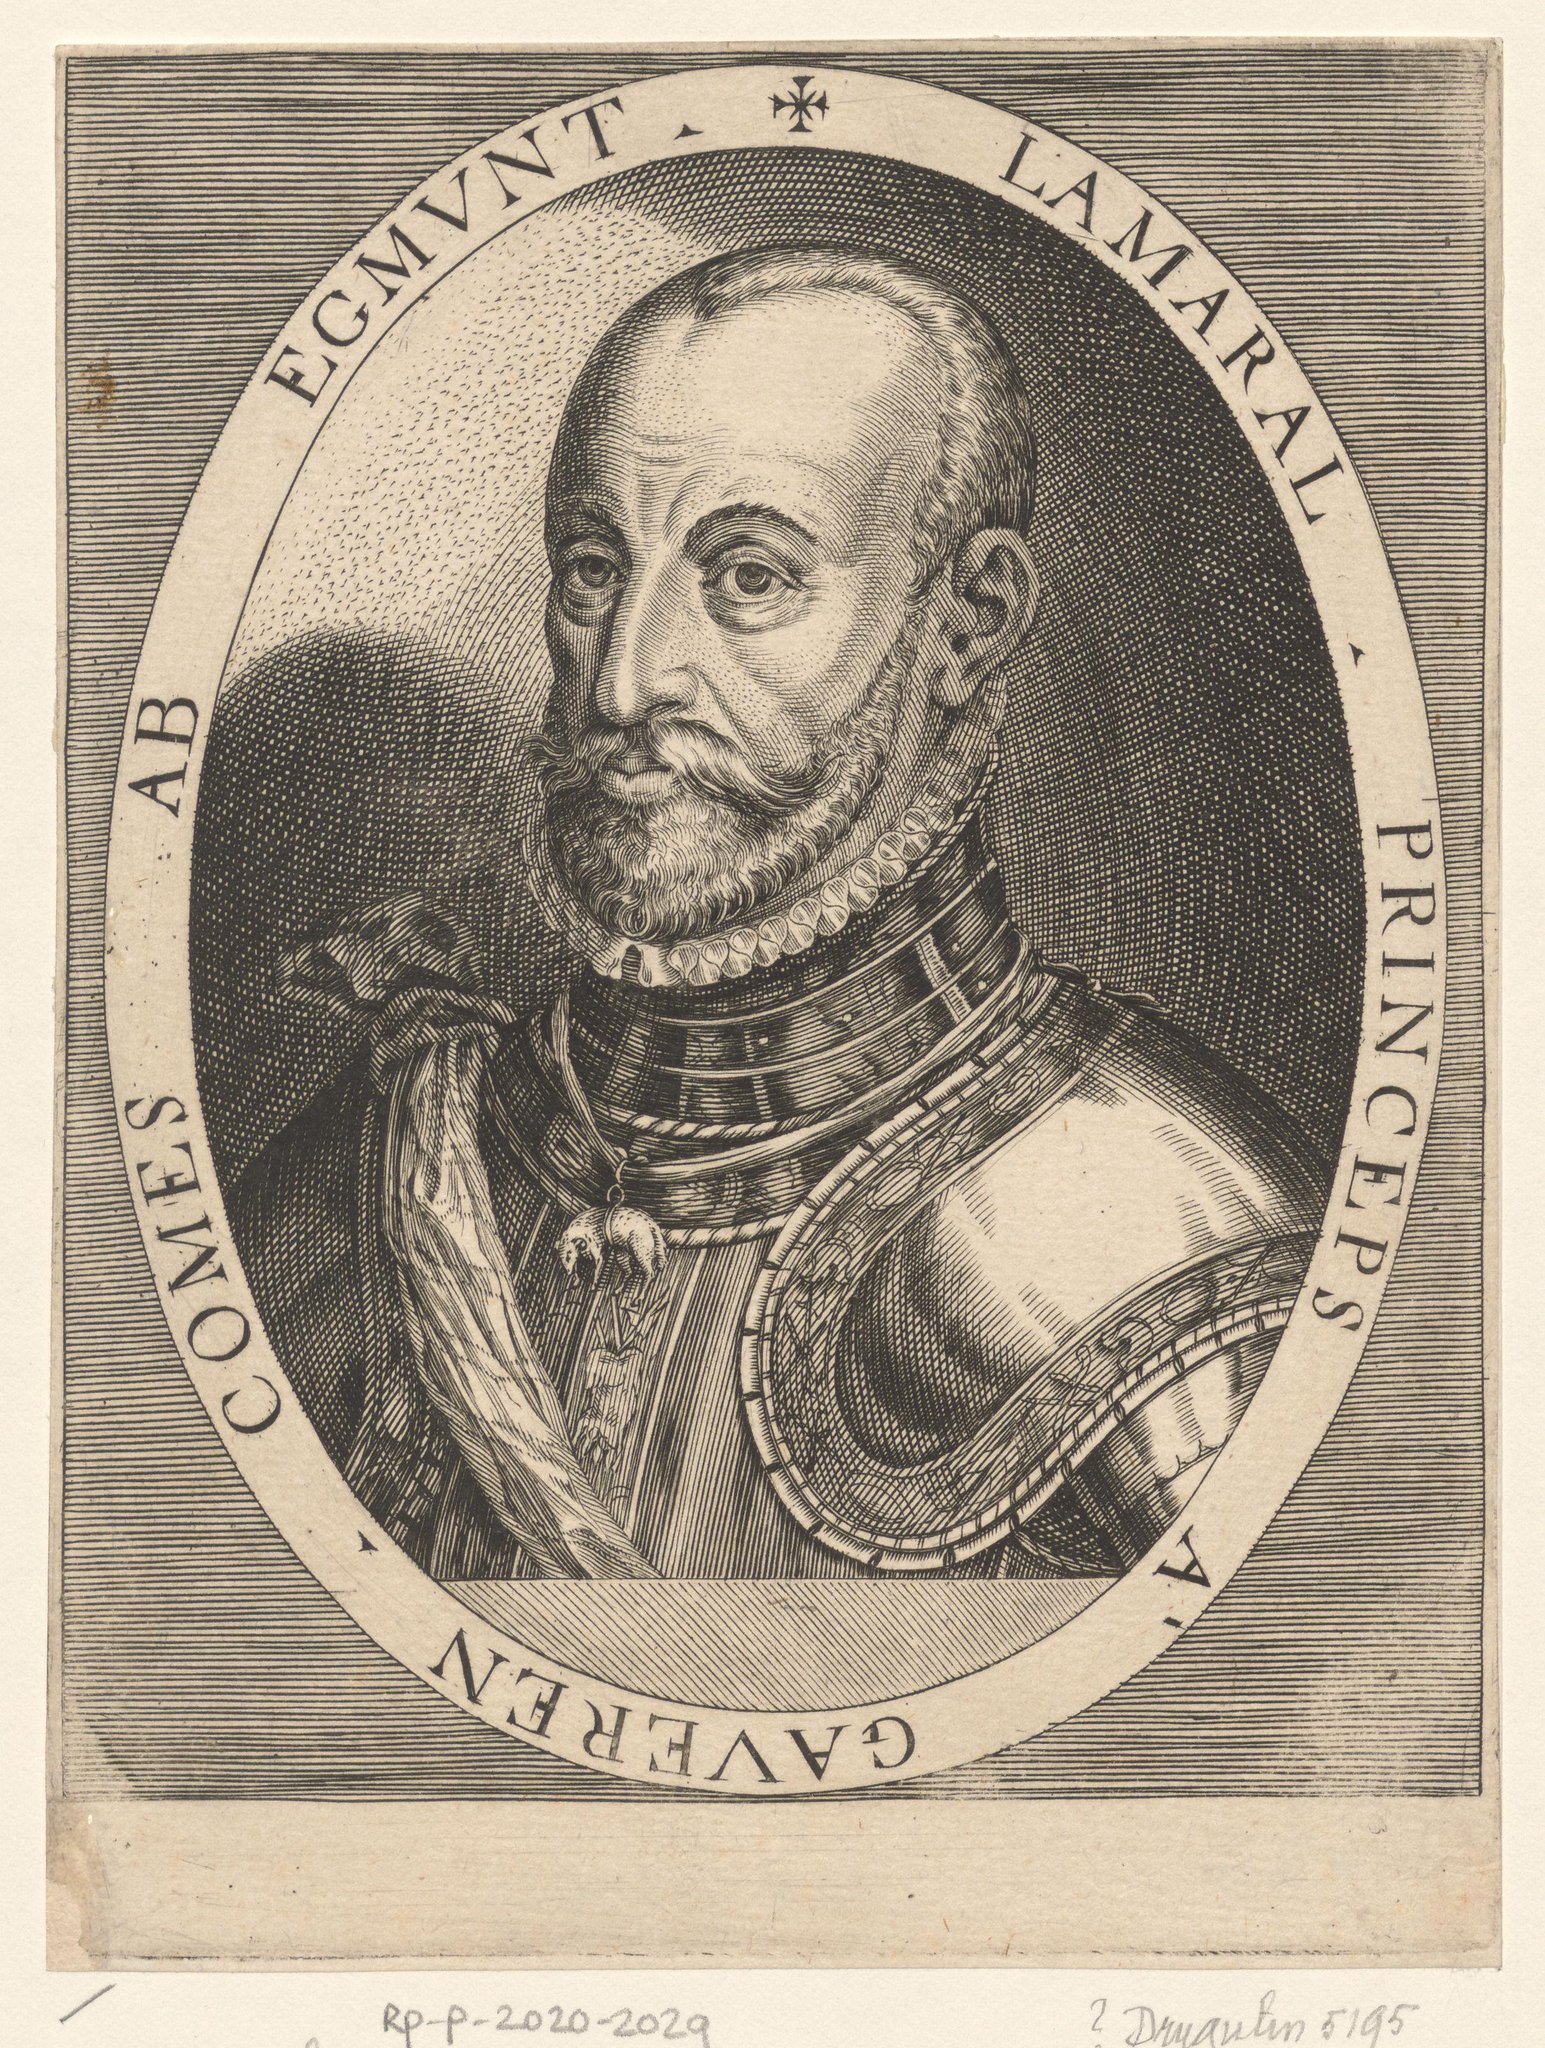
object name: print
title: Portret van Lamoraal van Egmond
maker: dominicus custos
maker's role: print maker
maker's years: 1560-1615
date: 1601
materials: paper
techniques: engraving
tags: brussels, armour, historical persons, knighthood order of the golden fleece